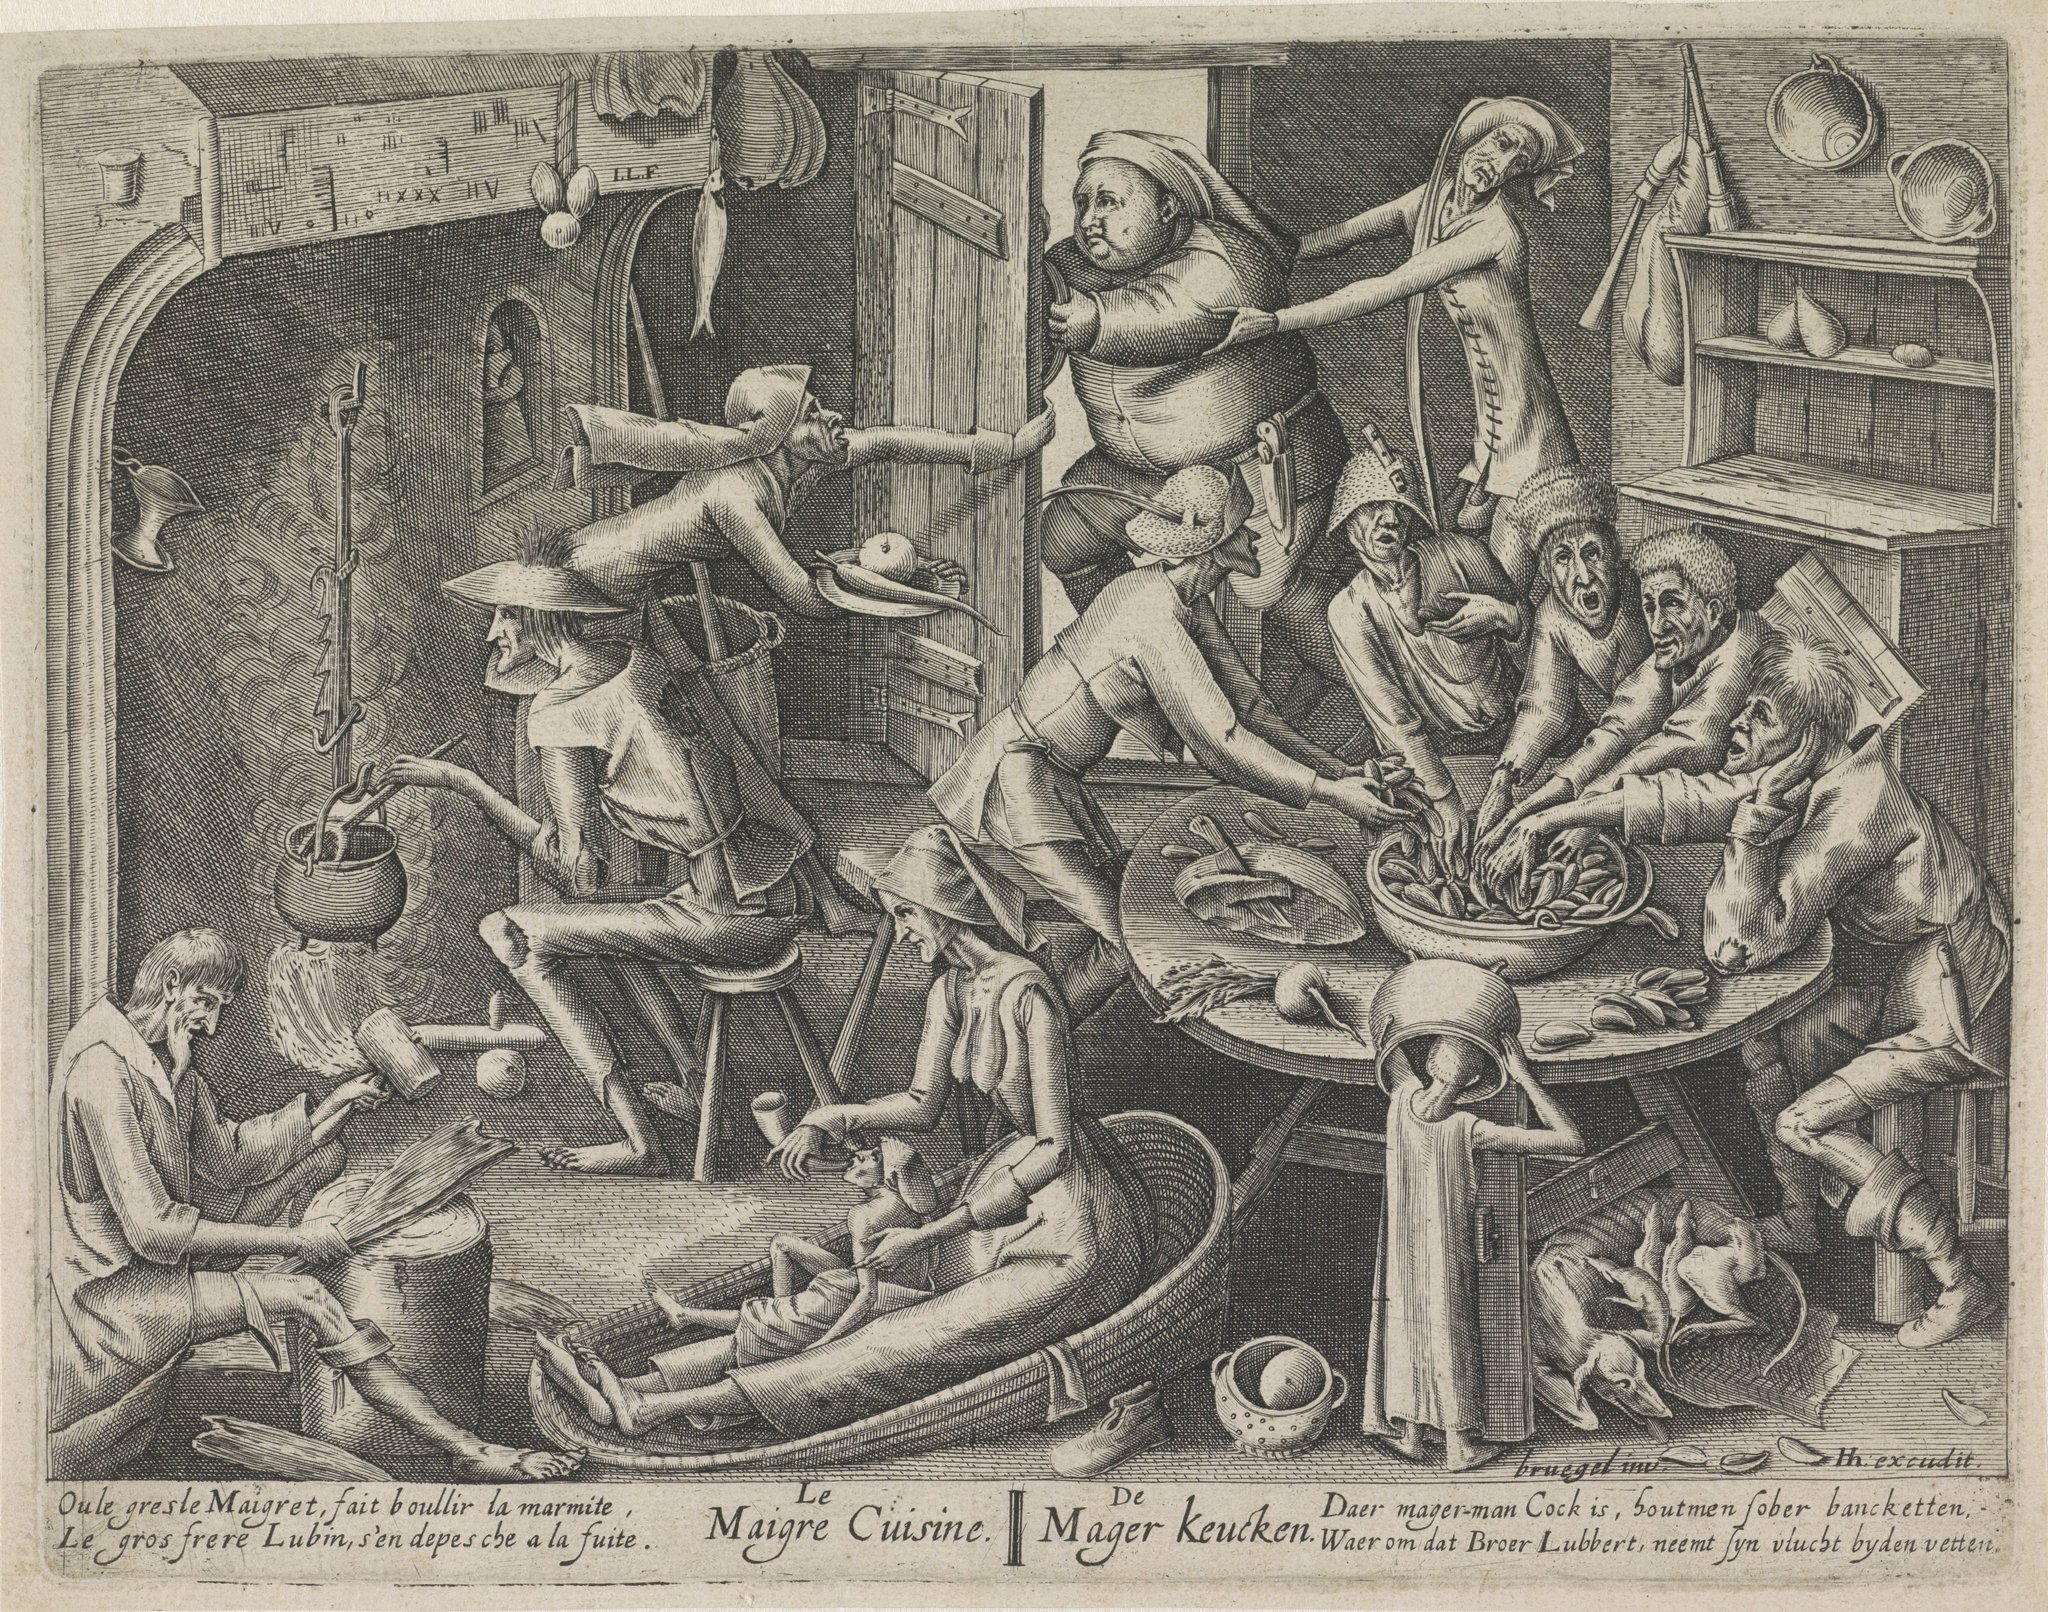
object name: print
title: Le Maigre Cuisine / De Mager Keucken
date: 1597-1649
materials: paper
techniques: engraving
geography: the hague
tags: nursing-chair (dutch: 'bakermat'), thin (human type), kitchen-interior, poor kitchen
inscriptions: collector's mark: Lugt 2228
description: Keukeninterieur met magere mensen die aan een tafel mosselen eten. Een man roert in een ketel op het vuur en vooraan geeft een vrouw een kind uit een drinkhoorn te drinken. Boven probeert een dikke man de magere keuken te ontvluchten, terwijl twee magere mensen hem proberen binnen te halen. Onder de voorstelling een tweeregelig vers in het Frans en in het Nederlands.